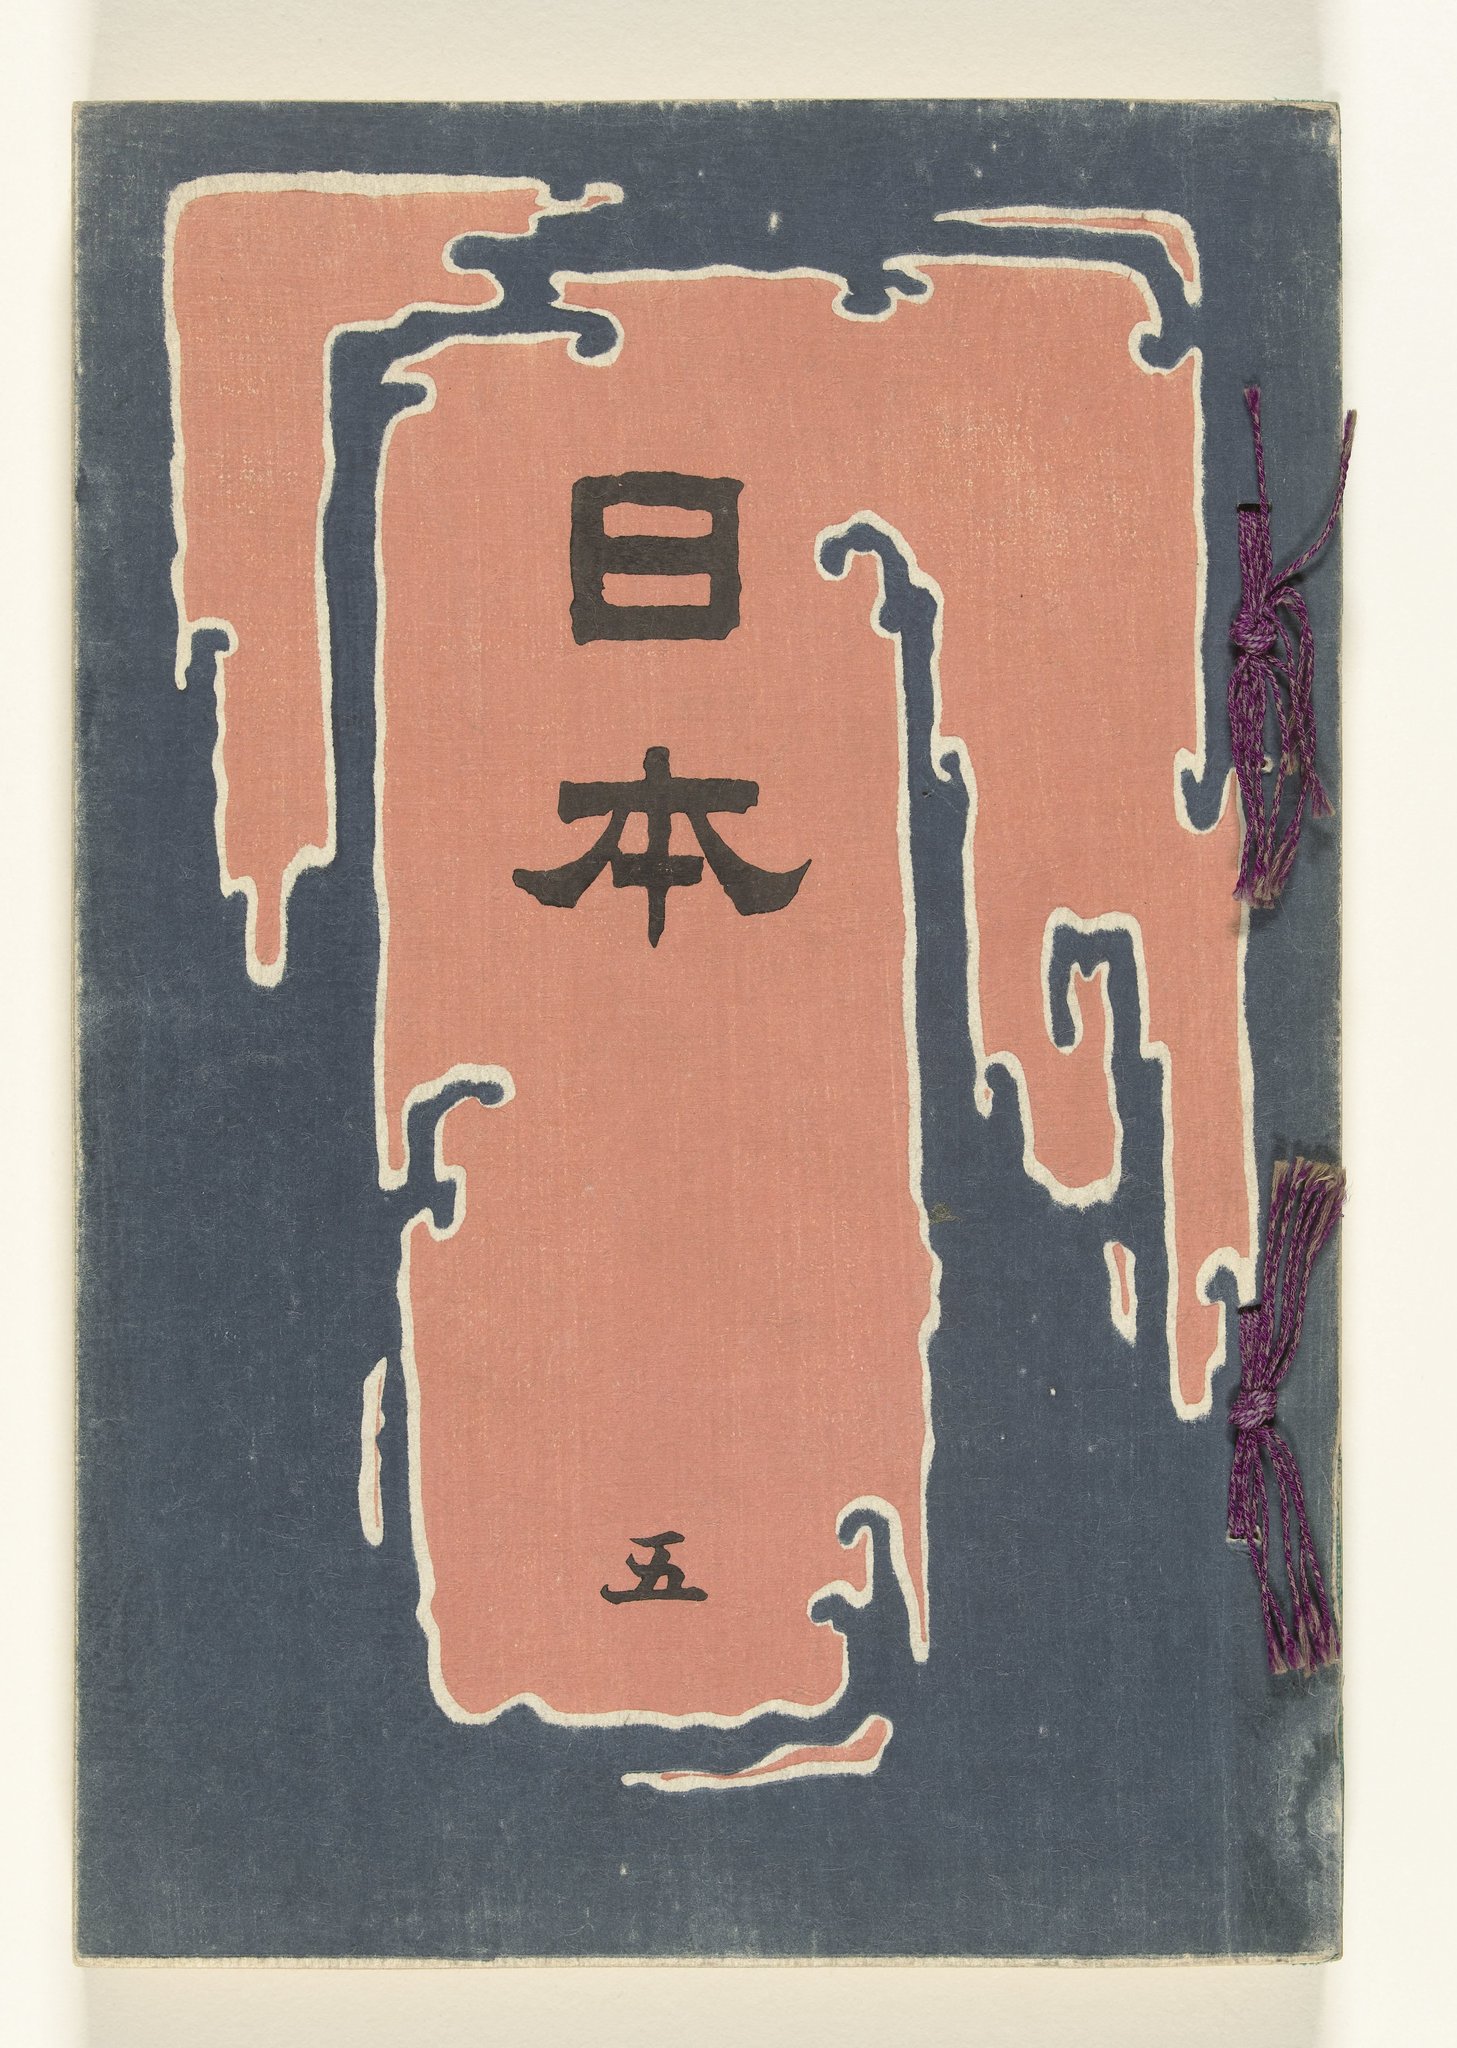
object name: book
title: Nihon - go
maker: Anonymous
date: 1868-1912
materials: paper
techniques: woodcut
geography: japan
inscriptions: collector's mark: ‘Rijksschool voor kunstnijverheid’ Lugt 3937